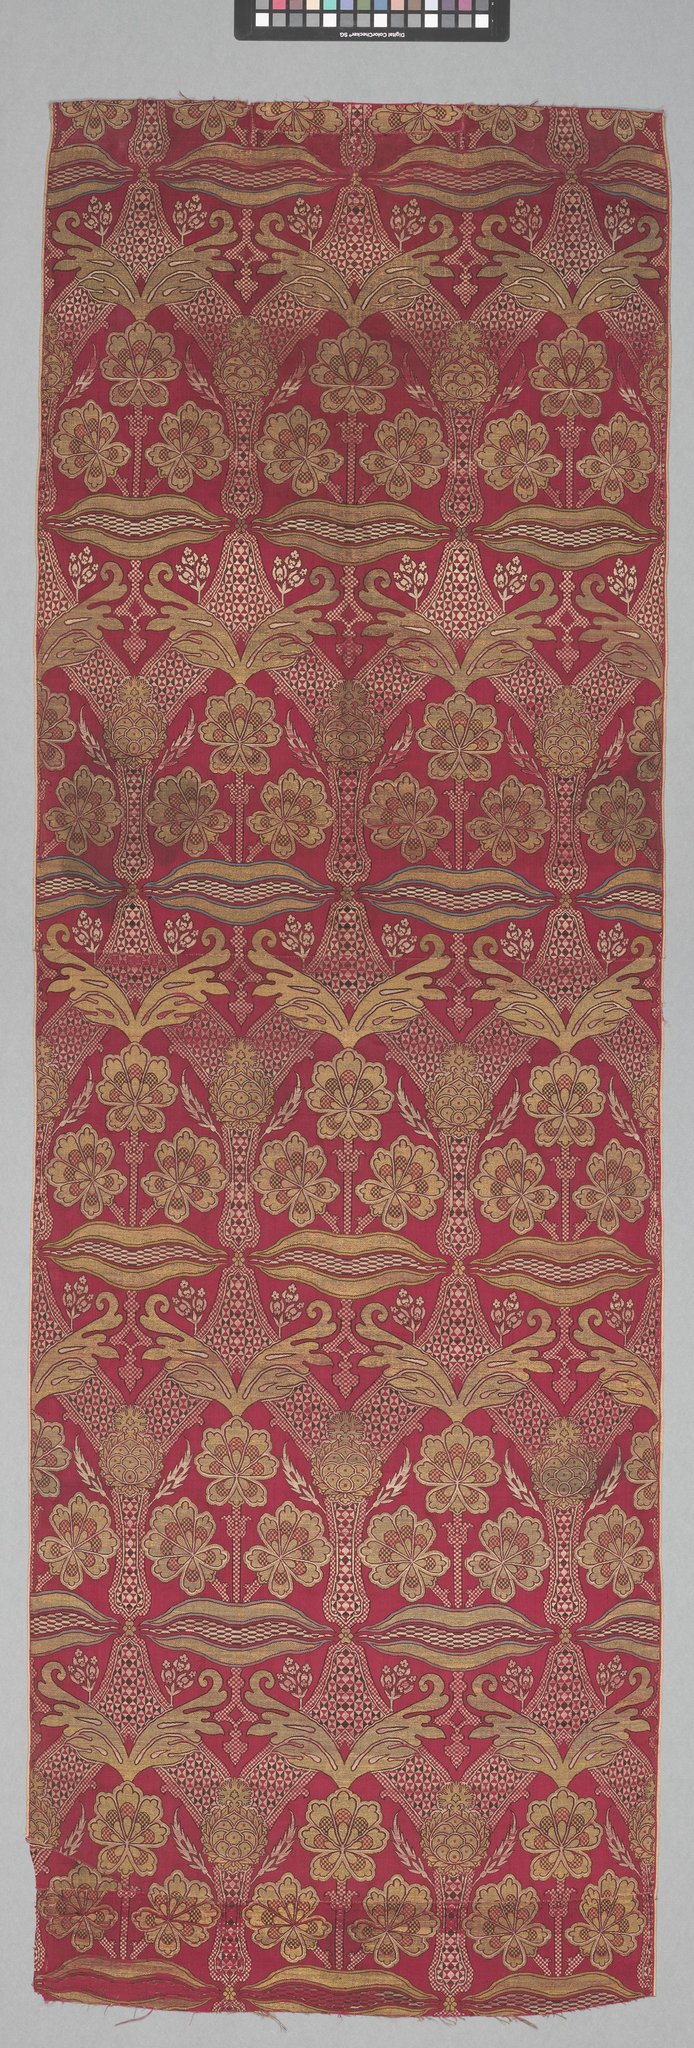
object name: textile fragment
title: Loom Width with Floral and Tiger-stripe Design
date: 1501-1600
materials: metal thread, silk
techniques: lampas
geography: turkey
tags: flowers